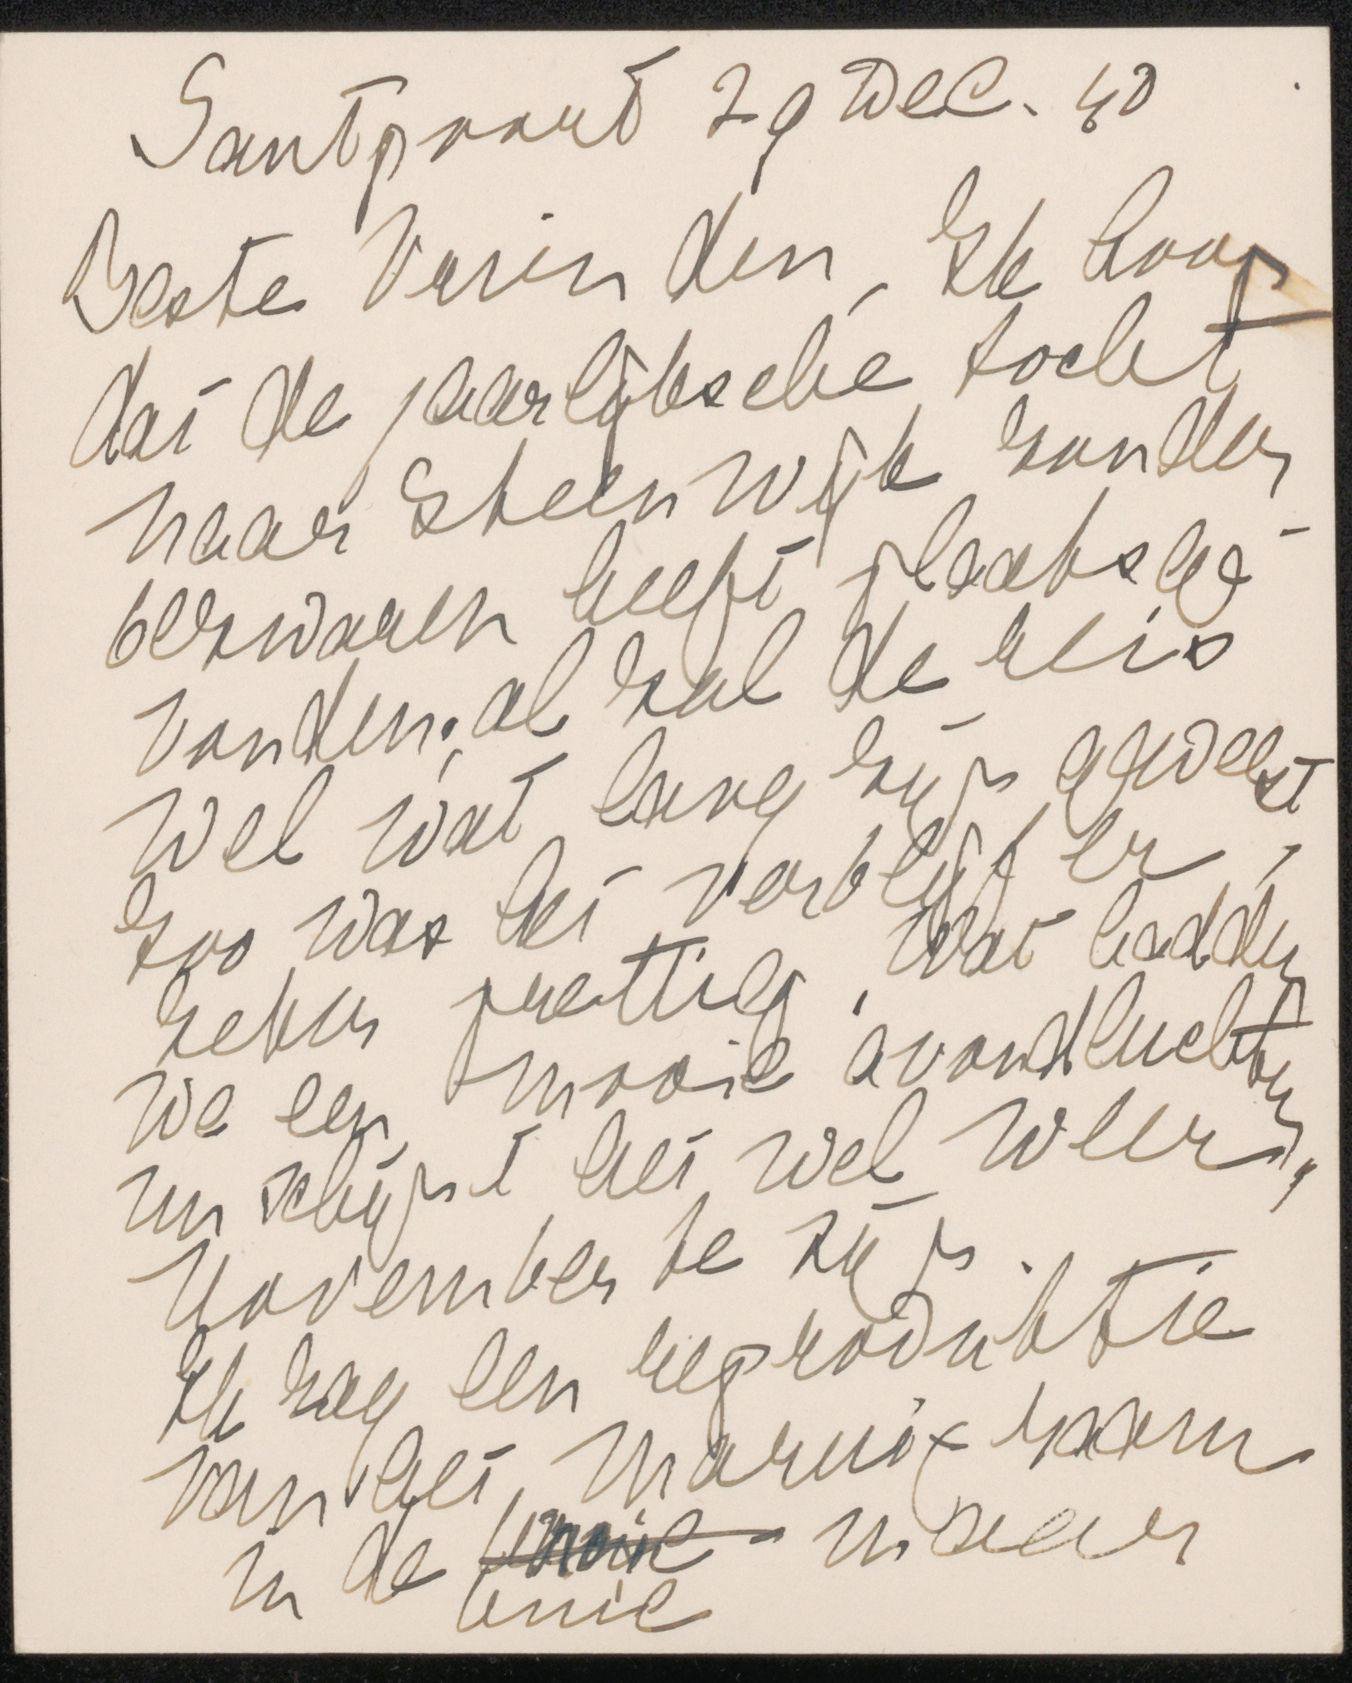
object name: postcard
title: Briefkaart aan Willem Bogtman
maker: henriëtte roland holst-van der schalk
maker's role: dichter, schrijver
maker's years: 1869-1952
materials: ink, paper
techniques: pen, writing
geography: santpoort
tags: willem bogtman, applied arts, arts and crafts; industrial design